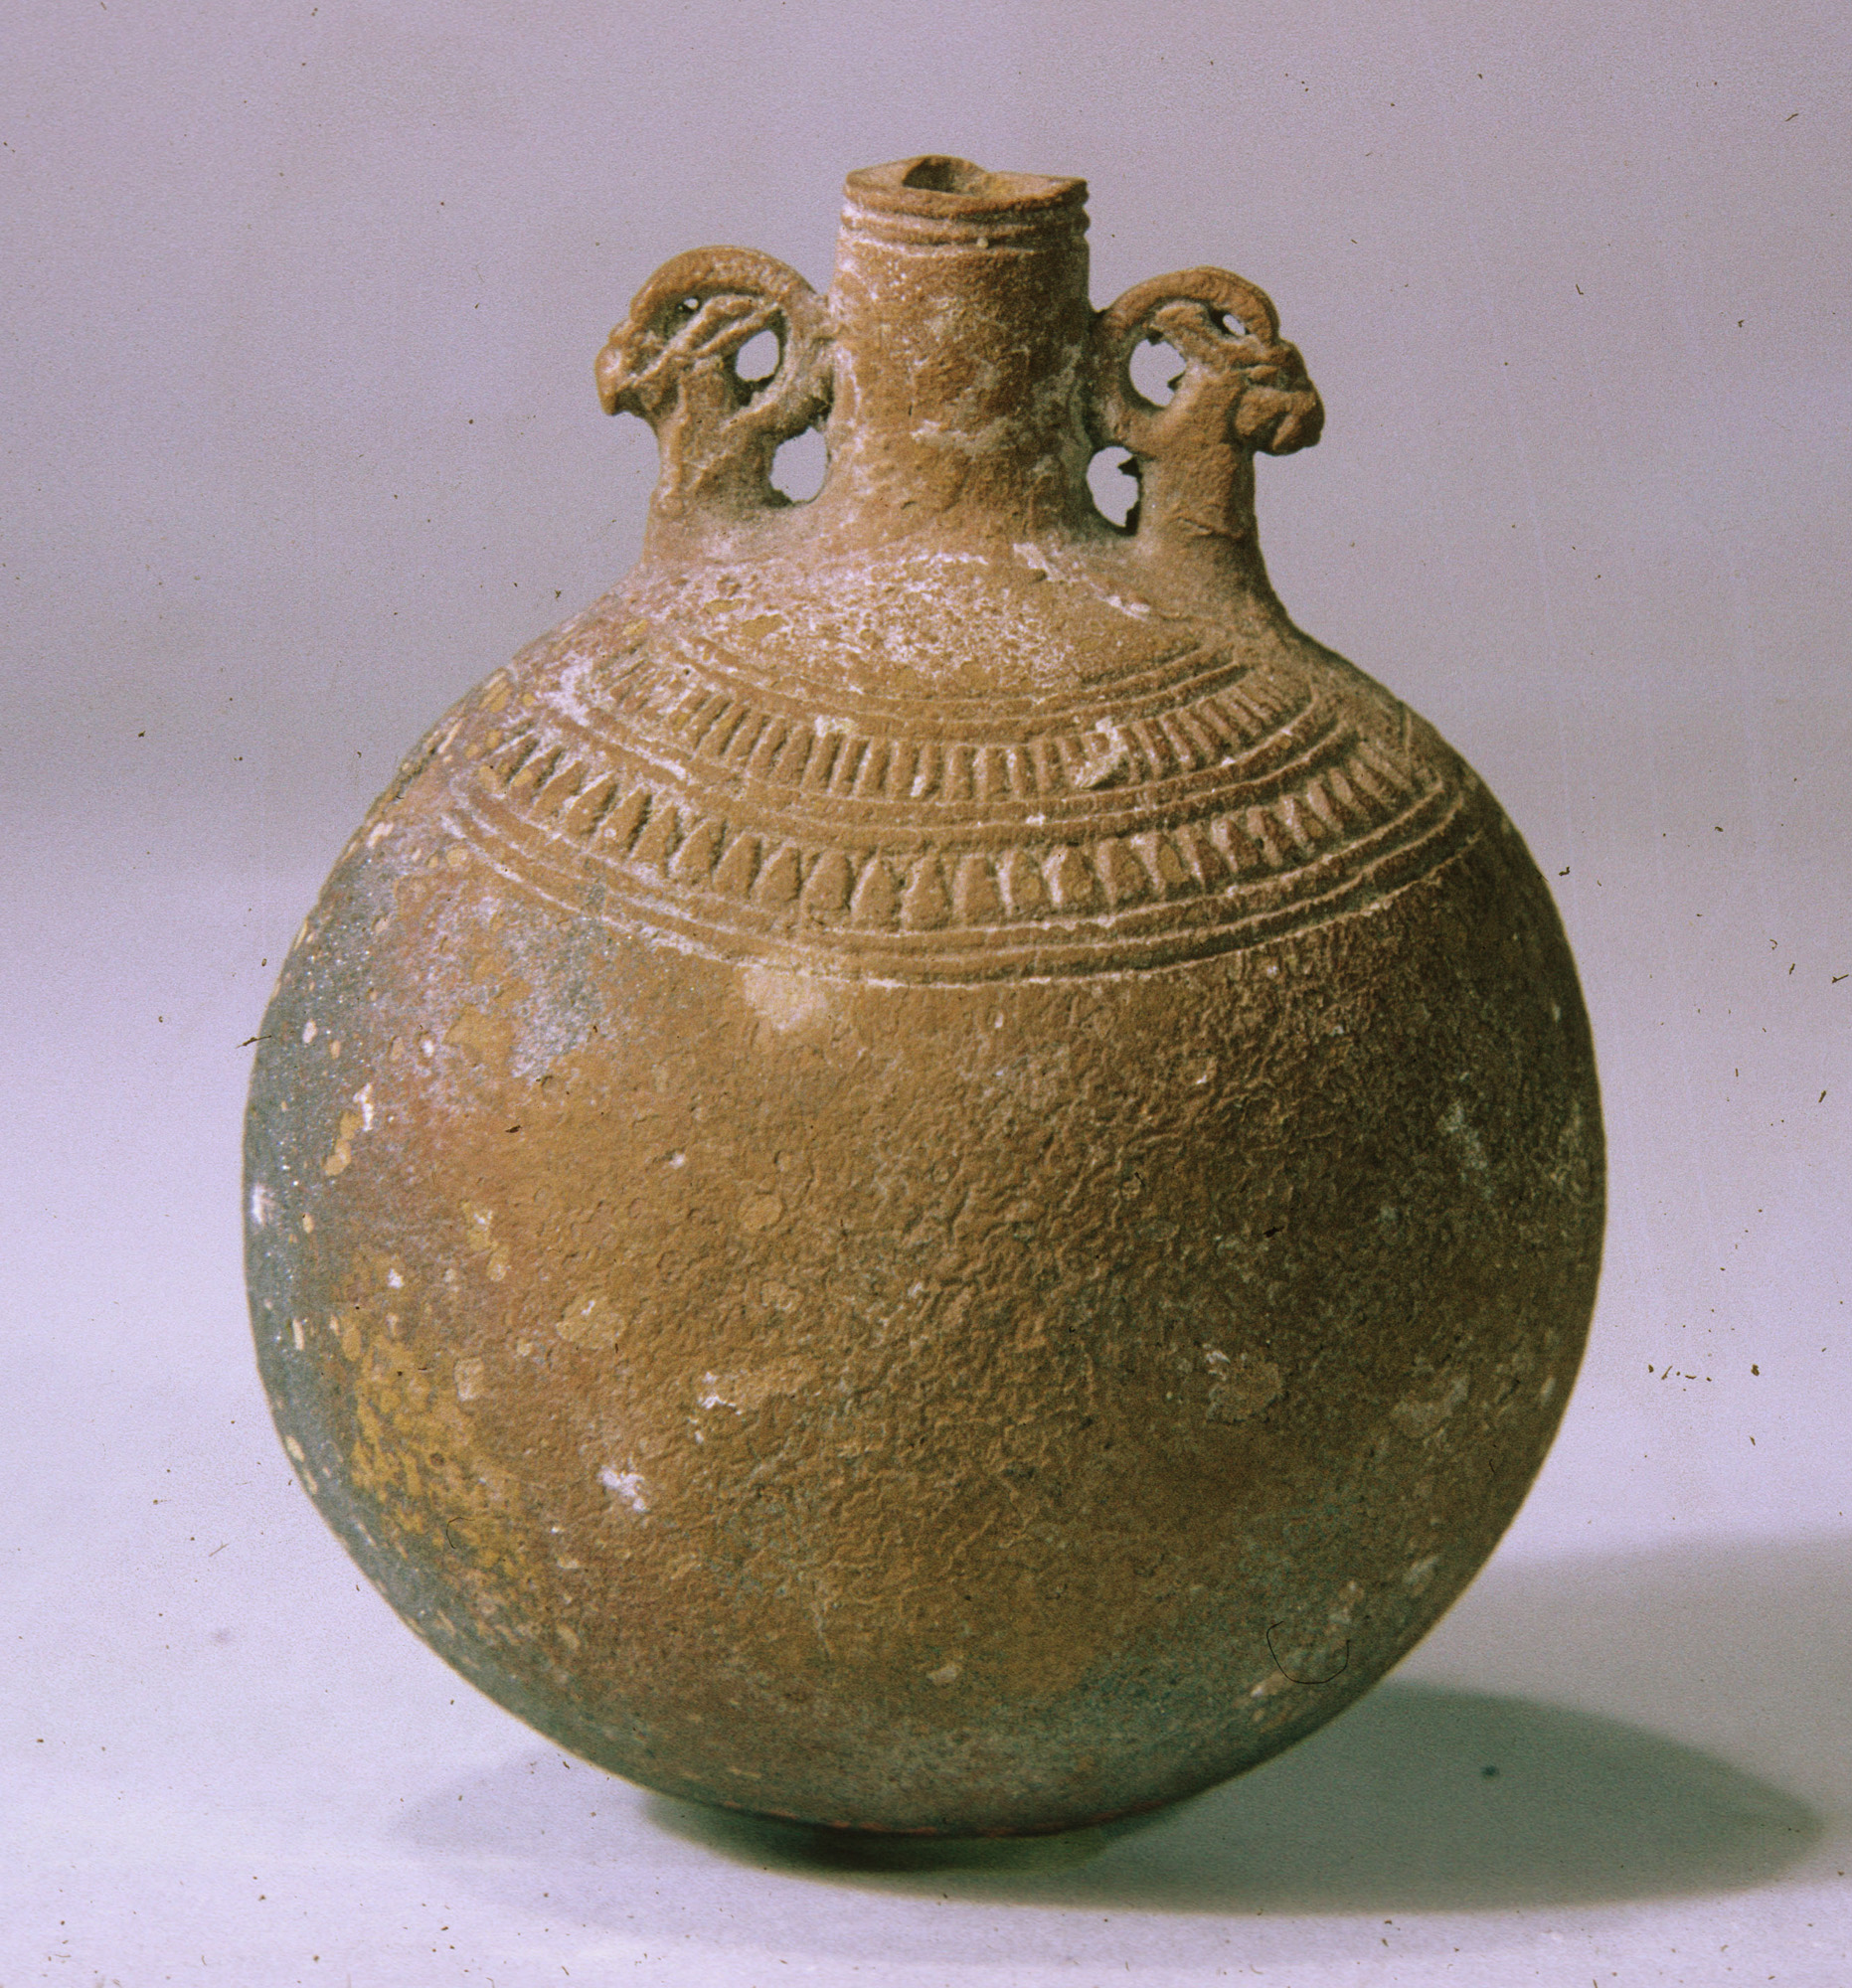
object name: lentoid bottle, new year's bottle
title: Lentoid Bottle ("New Year's Bottle")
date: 664-525 BCE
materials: faience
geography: egypt